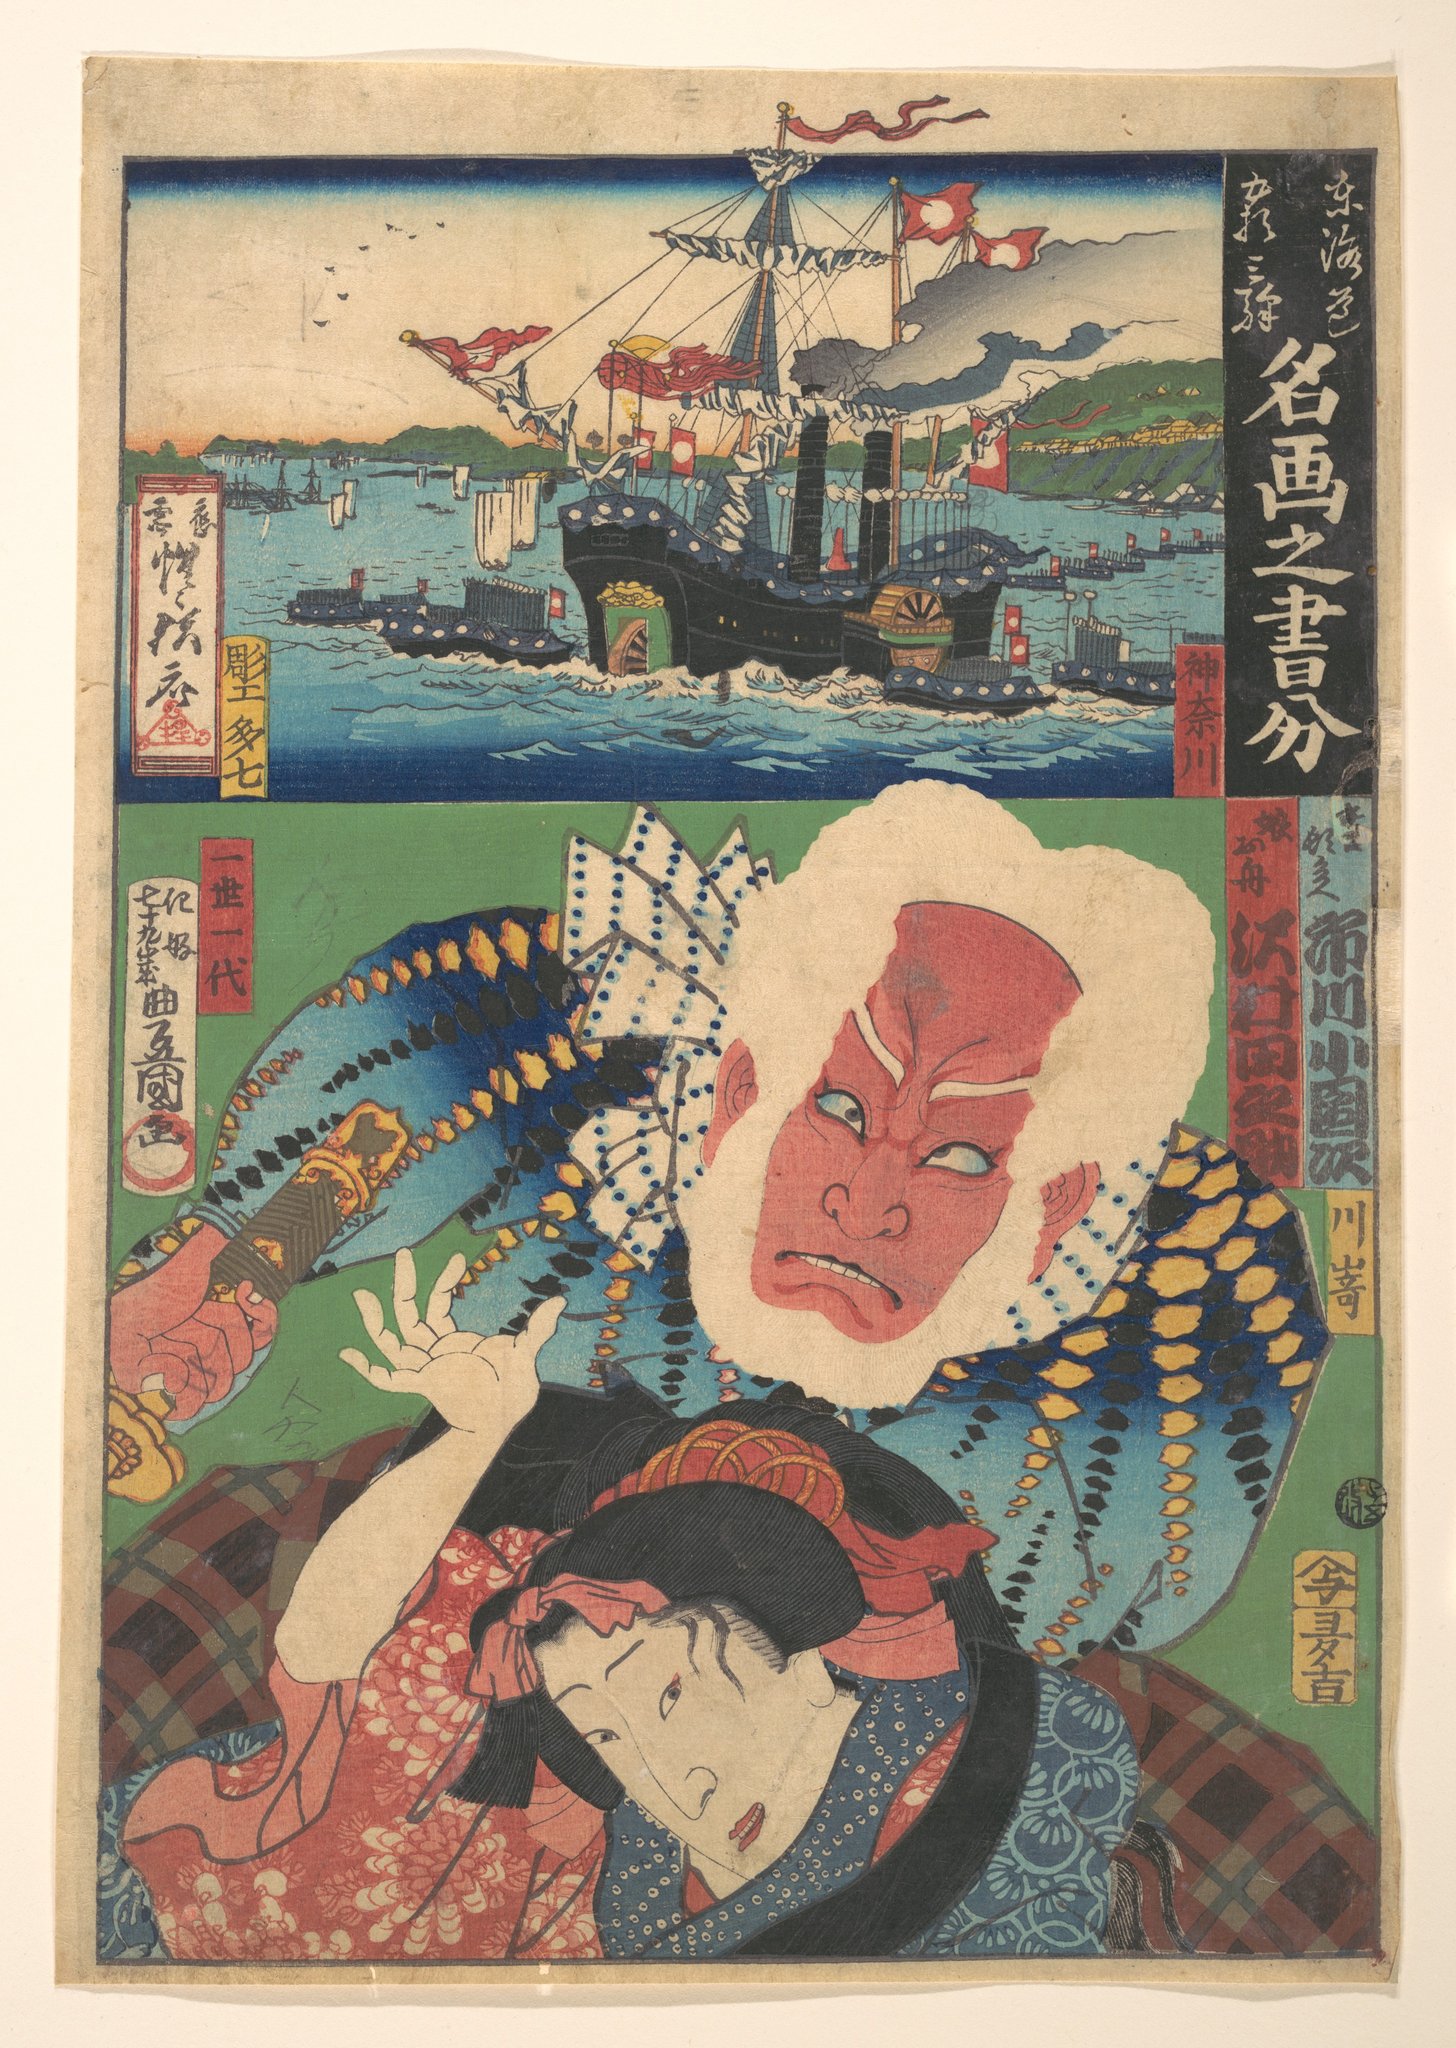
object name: print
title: Fifty-Three Stations of the Tōkaidō: Inspired by Famous Pictures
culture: japanese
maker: utagawa kunisada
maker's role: artist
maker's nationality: japanese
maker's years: 1786-1864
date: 1864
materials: ink, paper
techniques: woodblock print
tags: men,women,ships